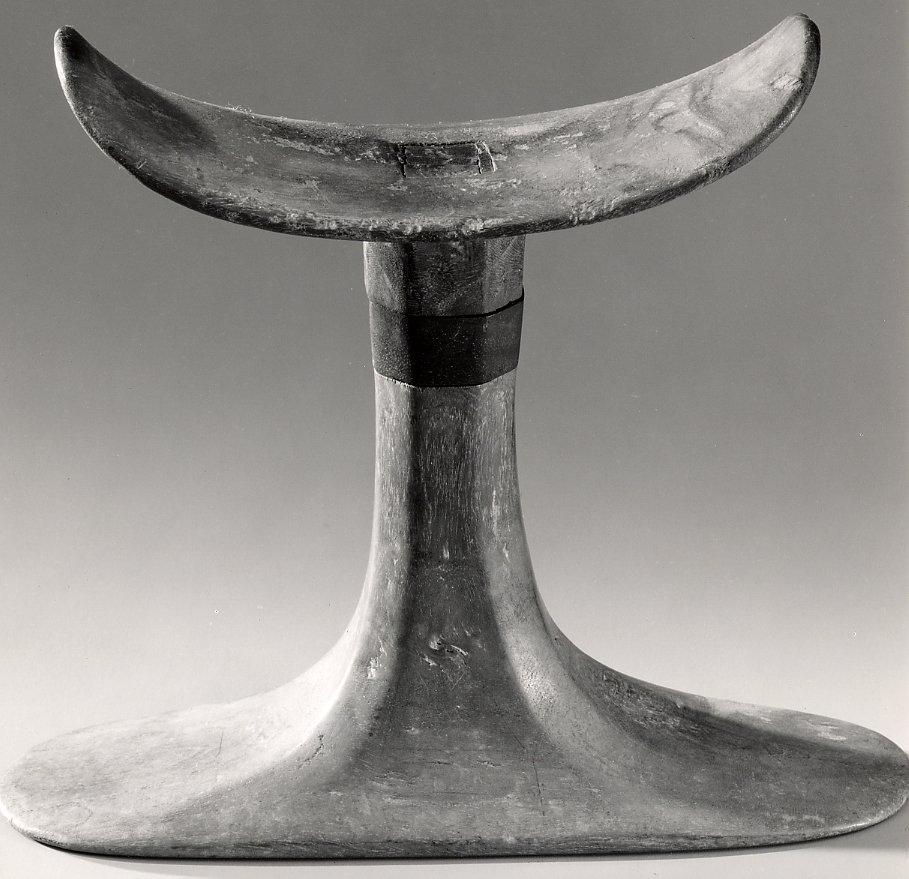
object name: headrest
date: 2030-1640 BCE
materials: wood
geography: egypt